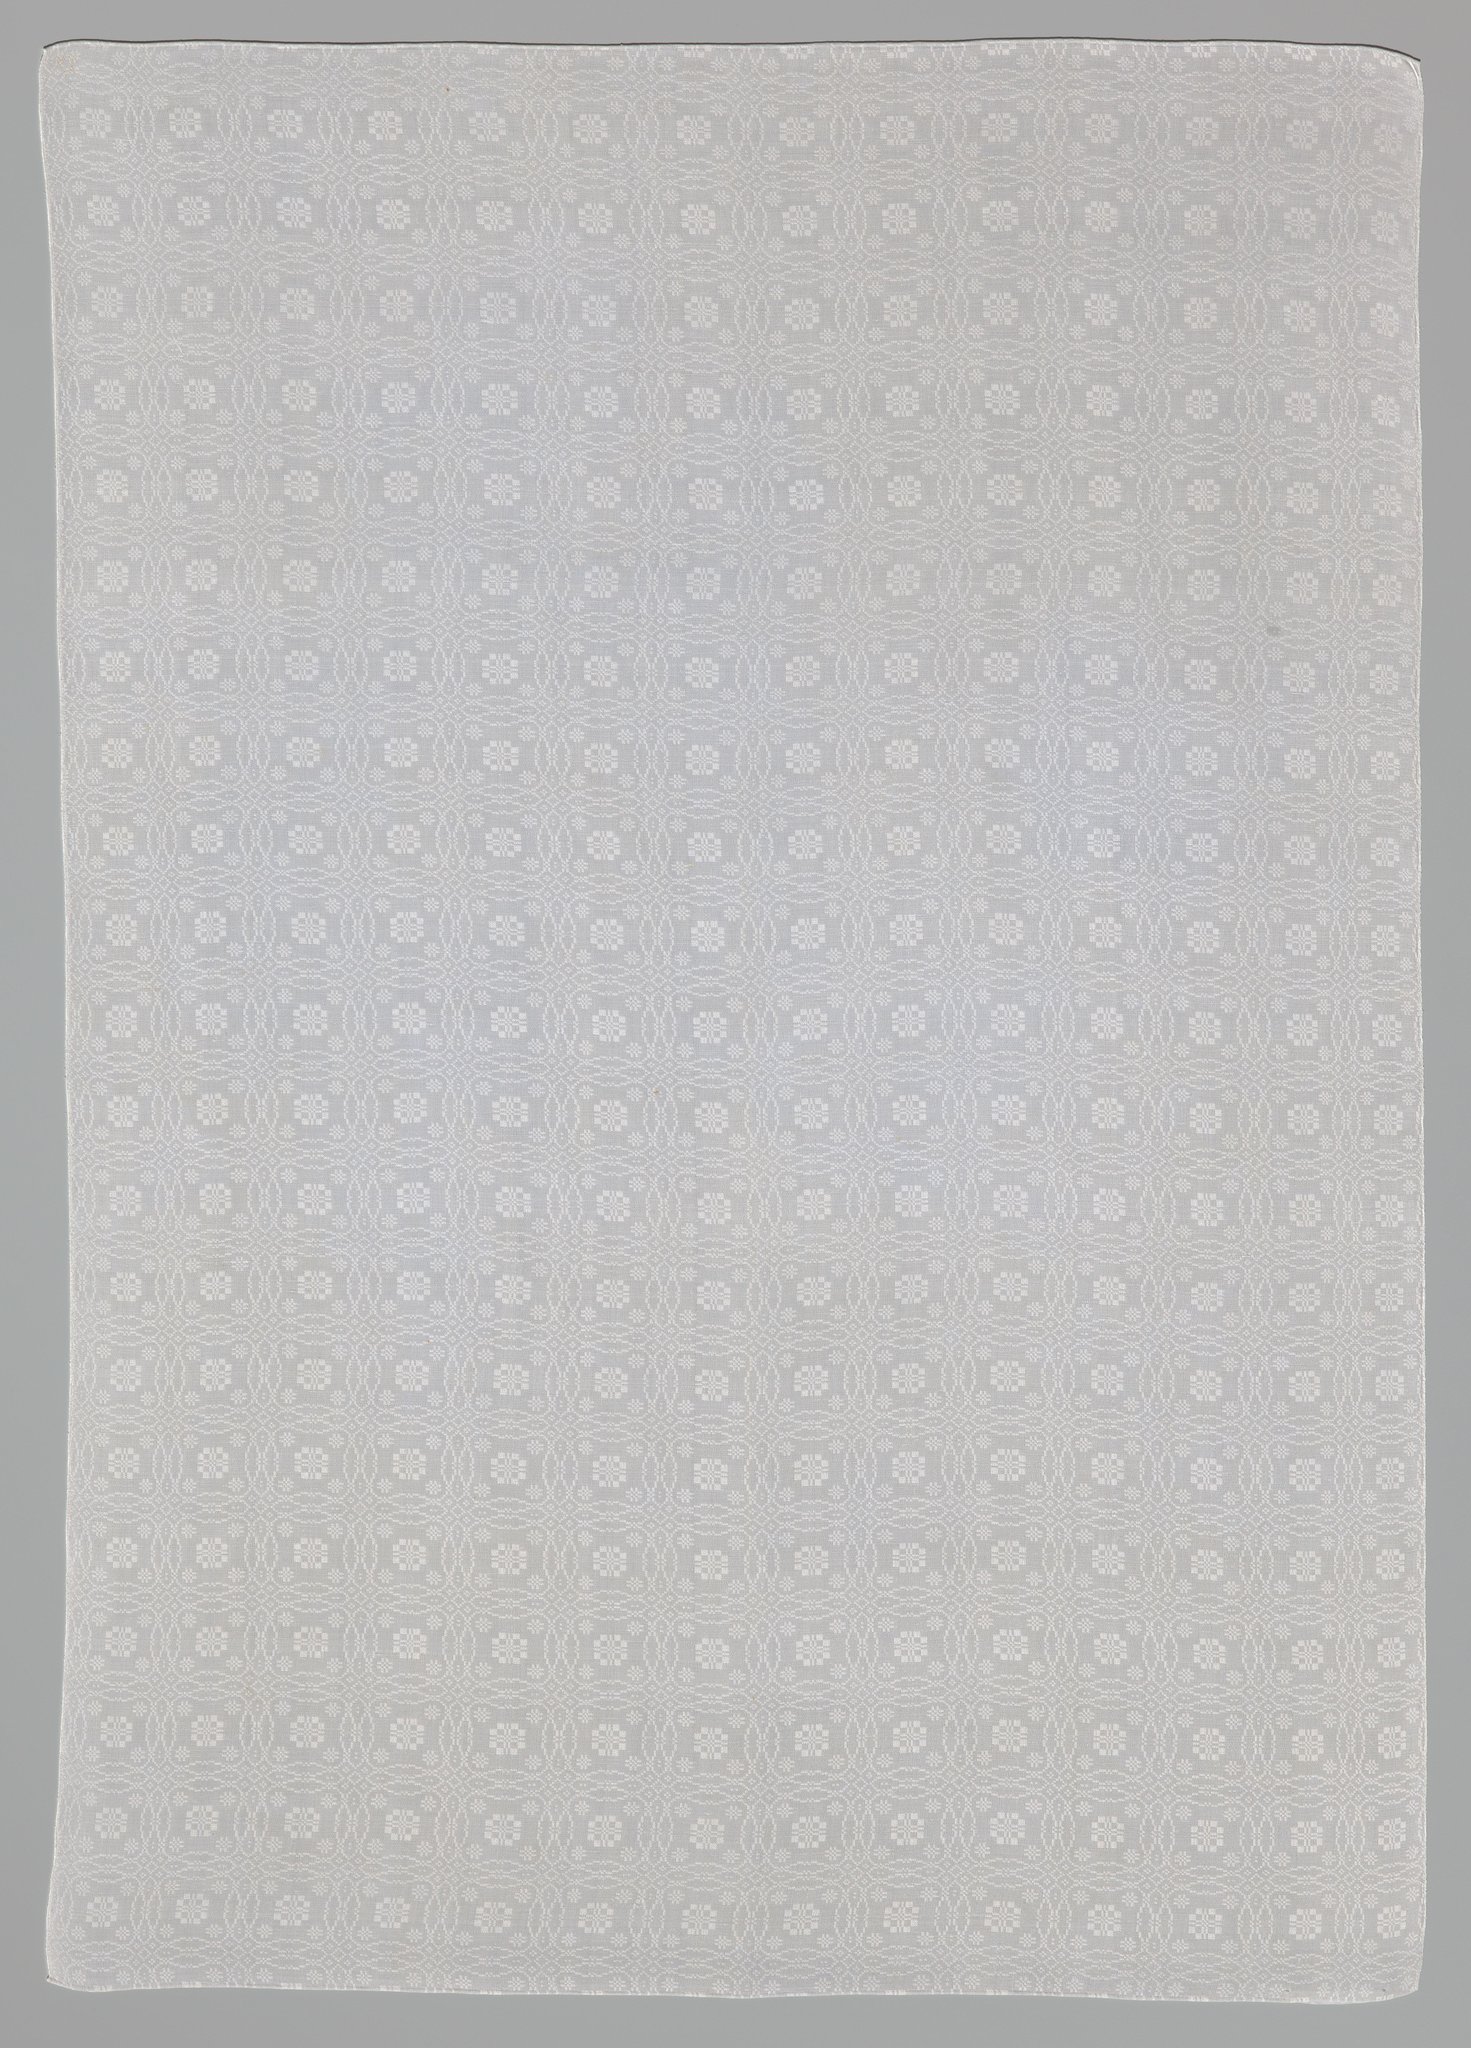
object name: napkin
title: Wit linnen pellen servet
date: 1660-1700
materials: linen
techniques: peeled fabric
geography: northern netherlands